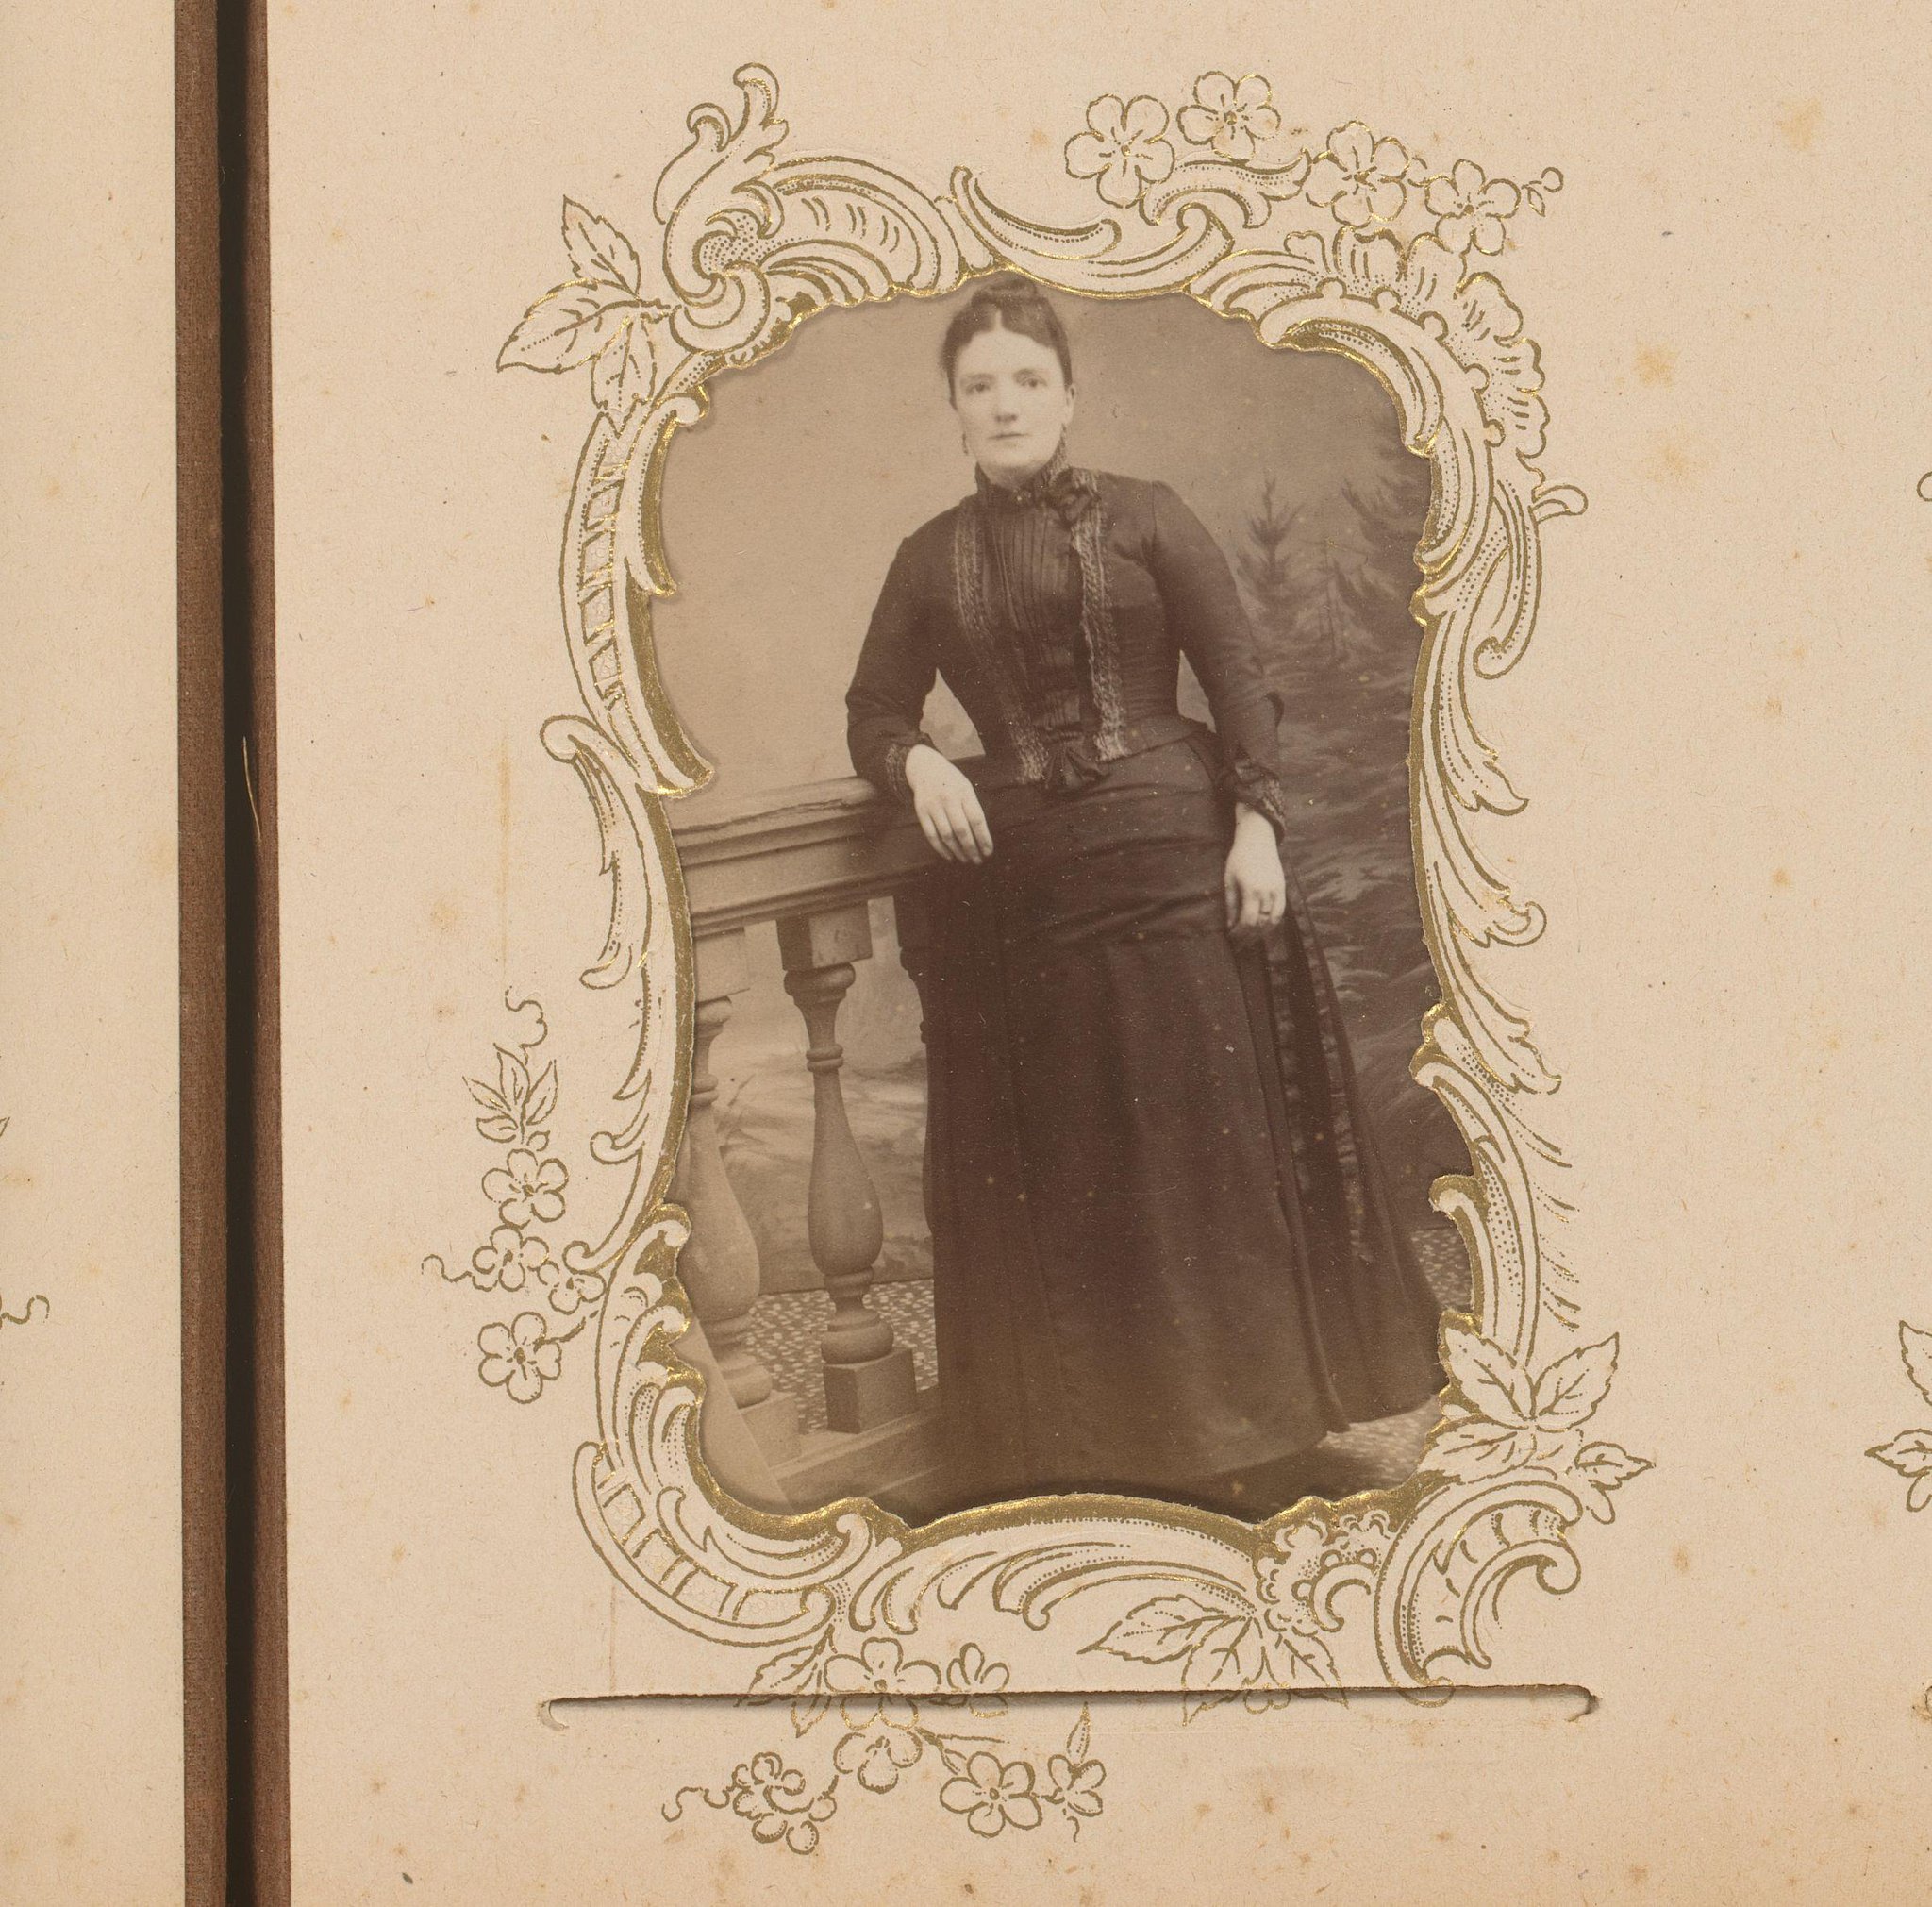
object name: photograph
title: Portret van een vrouw, leunend op een balustrade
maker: Anonymous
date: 1870-1900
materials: cardboard, photographic support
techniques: albumen print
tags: historical persons - bb - woman, leaning figure